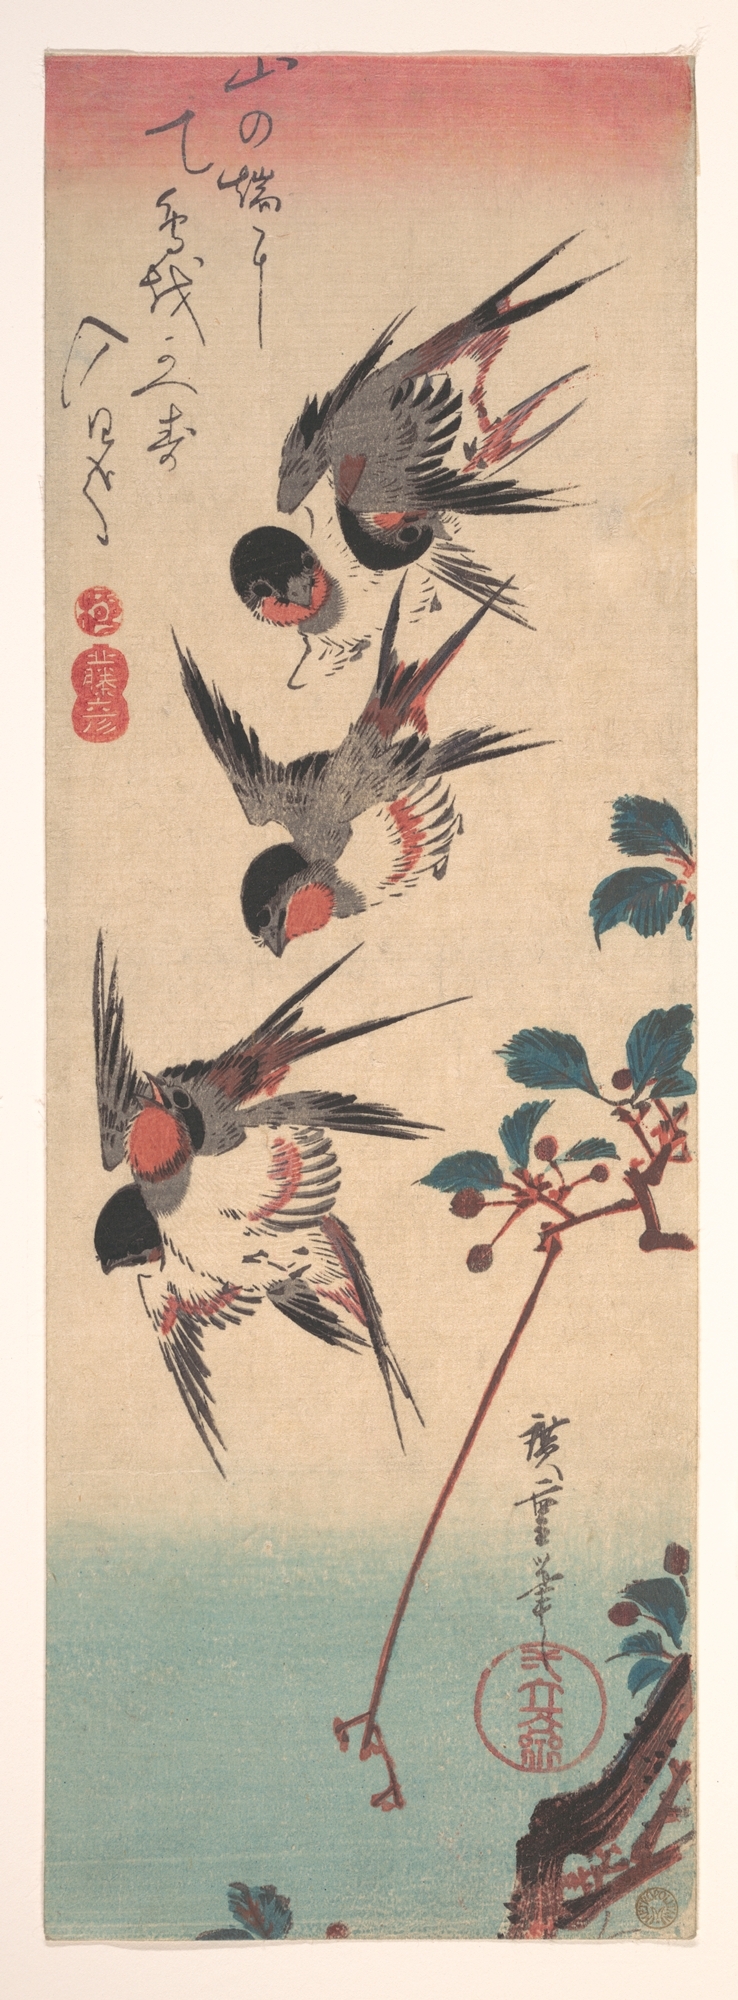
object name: print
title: Swallows and Wild Cherry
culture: japanese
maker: utagawa hiroshige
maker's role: artist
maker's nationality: japanese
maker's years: 1797-1858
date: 1834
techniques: woodblock print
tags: birds,leaves